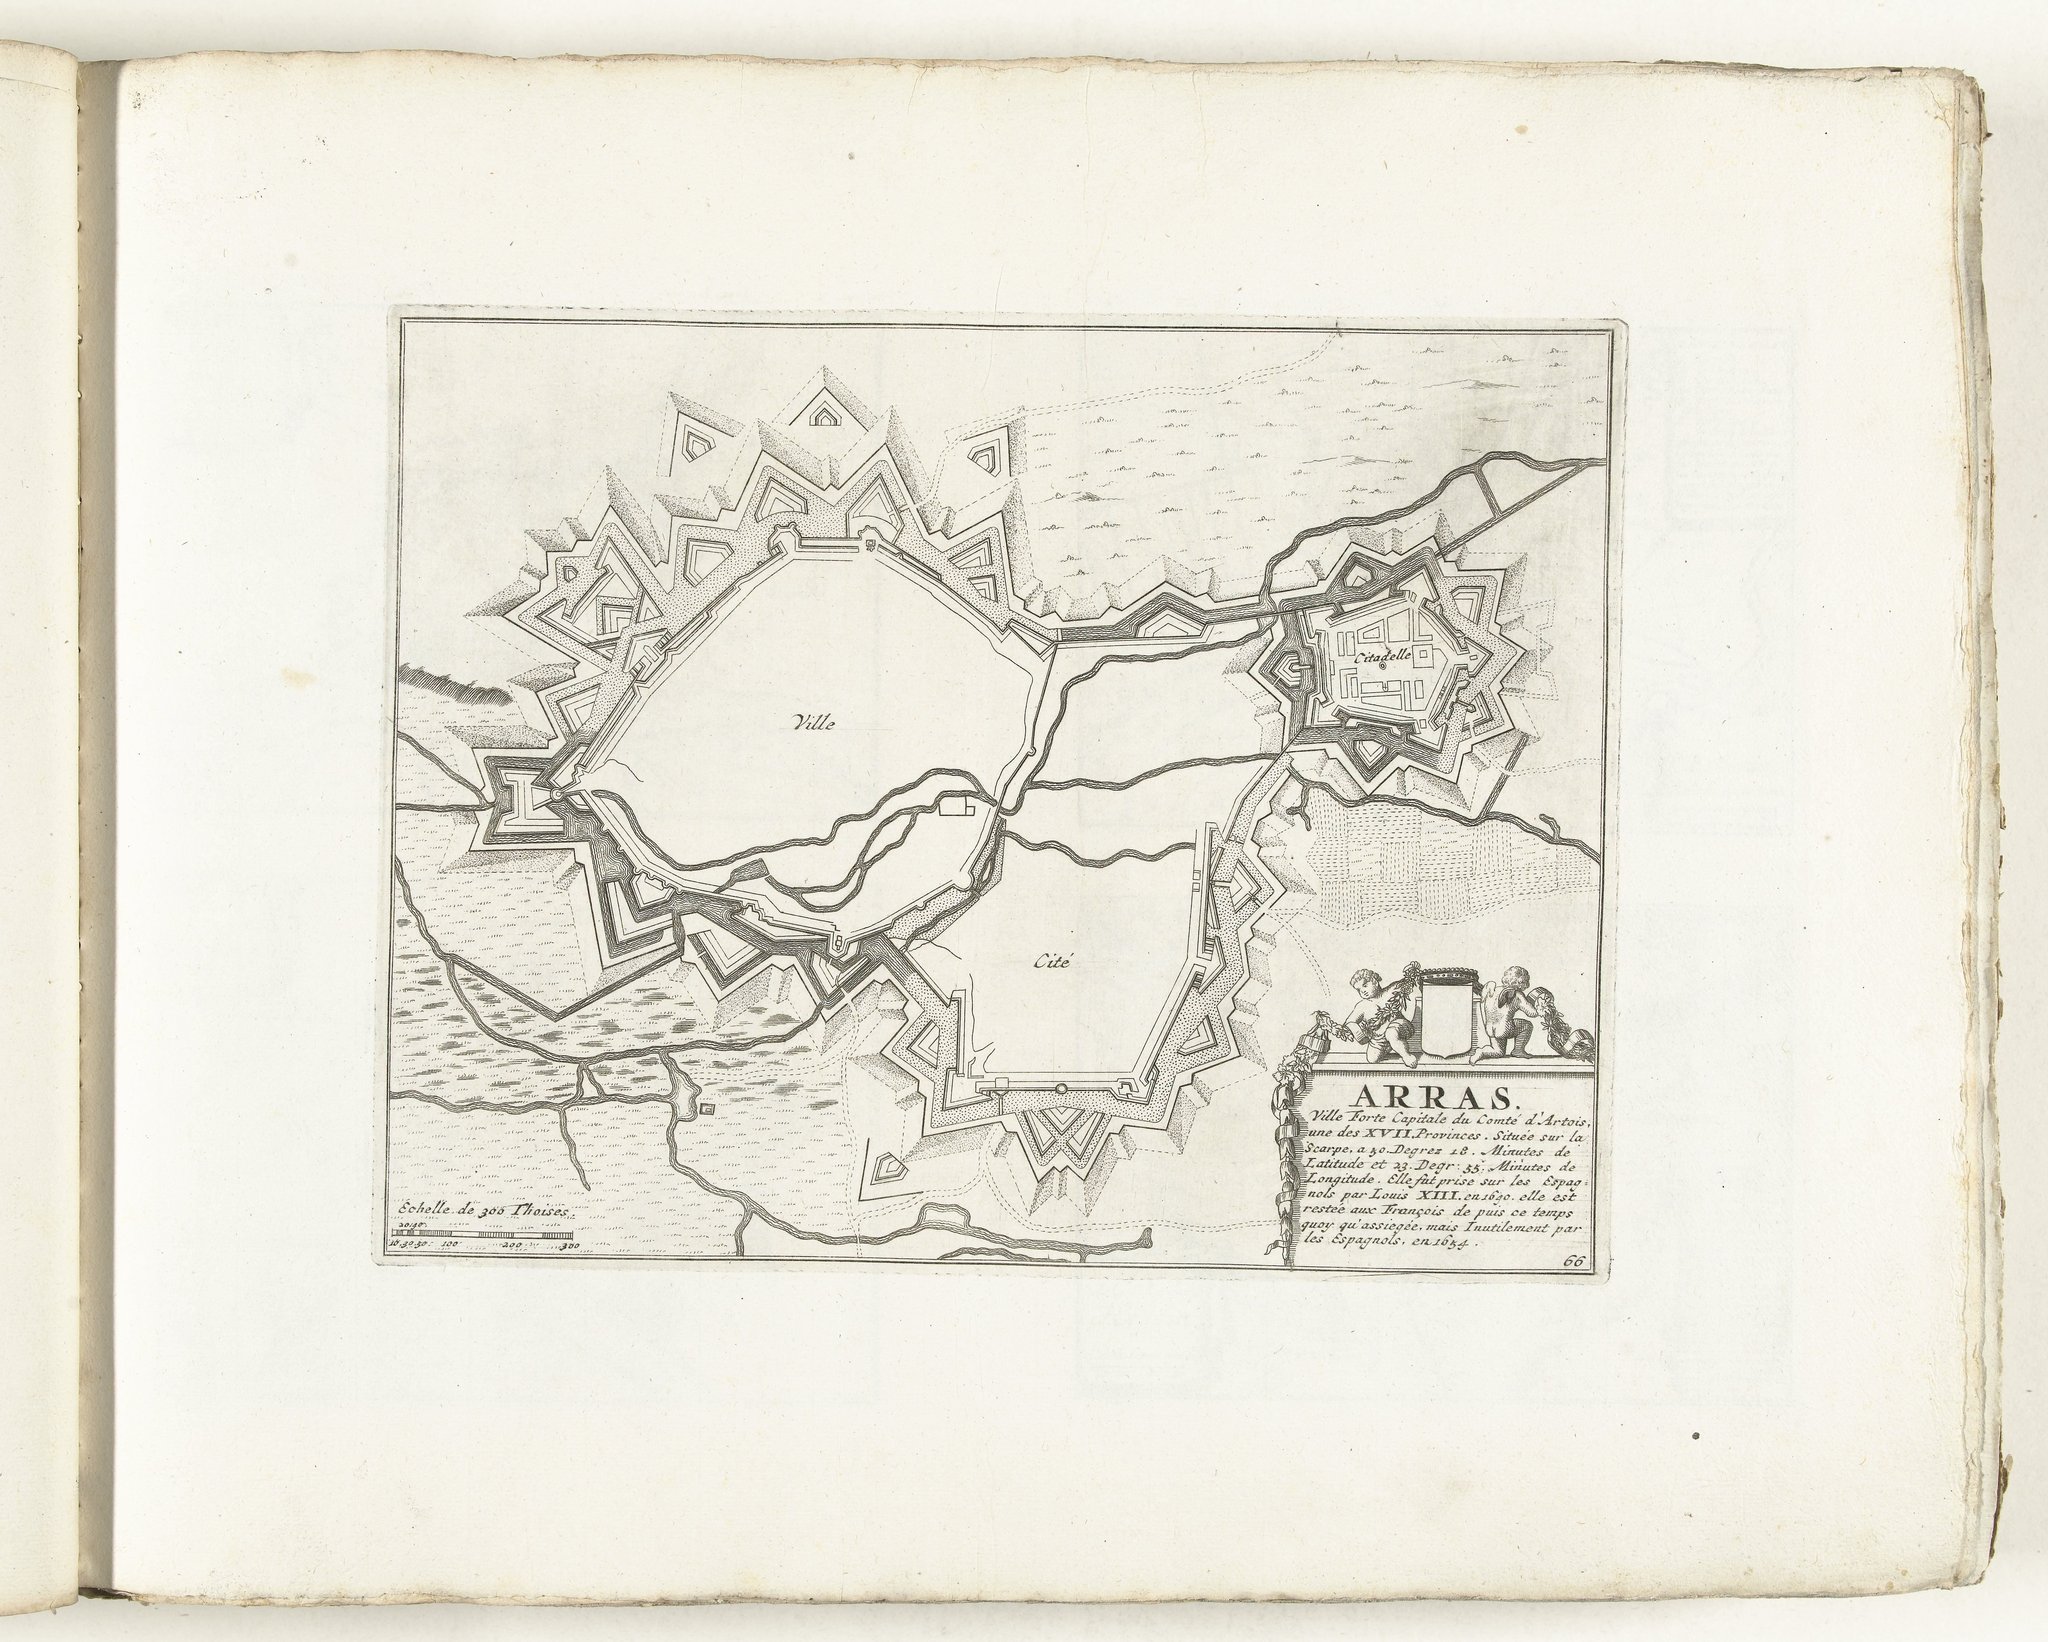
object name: print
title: Plattegrond van Arras, ca. 1702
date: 1702-1703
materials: paper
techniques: etching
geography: amsterdam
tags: fortress, maps of cities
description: Plattegrond van de verdedigingswerken om de stad Arras (Atrecht). Plaat nr. 66 in het prentwerk bestaande in totaal uit 276 genummerde platen van vermaarde sterke steden en vestingen in het kader van de Spaanse Successieoorlog. Voor het merendeel zijn deze platen gekopieerd naar de anonieme Franse platen: in Les forces de l'Europe en in: Le theatre de la guerre, dans les Pays-Bas, beide oorspronkelijk uitgegeven door Nicolas de Fer te Parijs (1693-1697) in het kader van de Negenjarige Oorlog. Titel en opschriften in de plaat in het Frans.